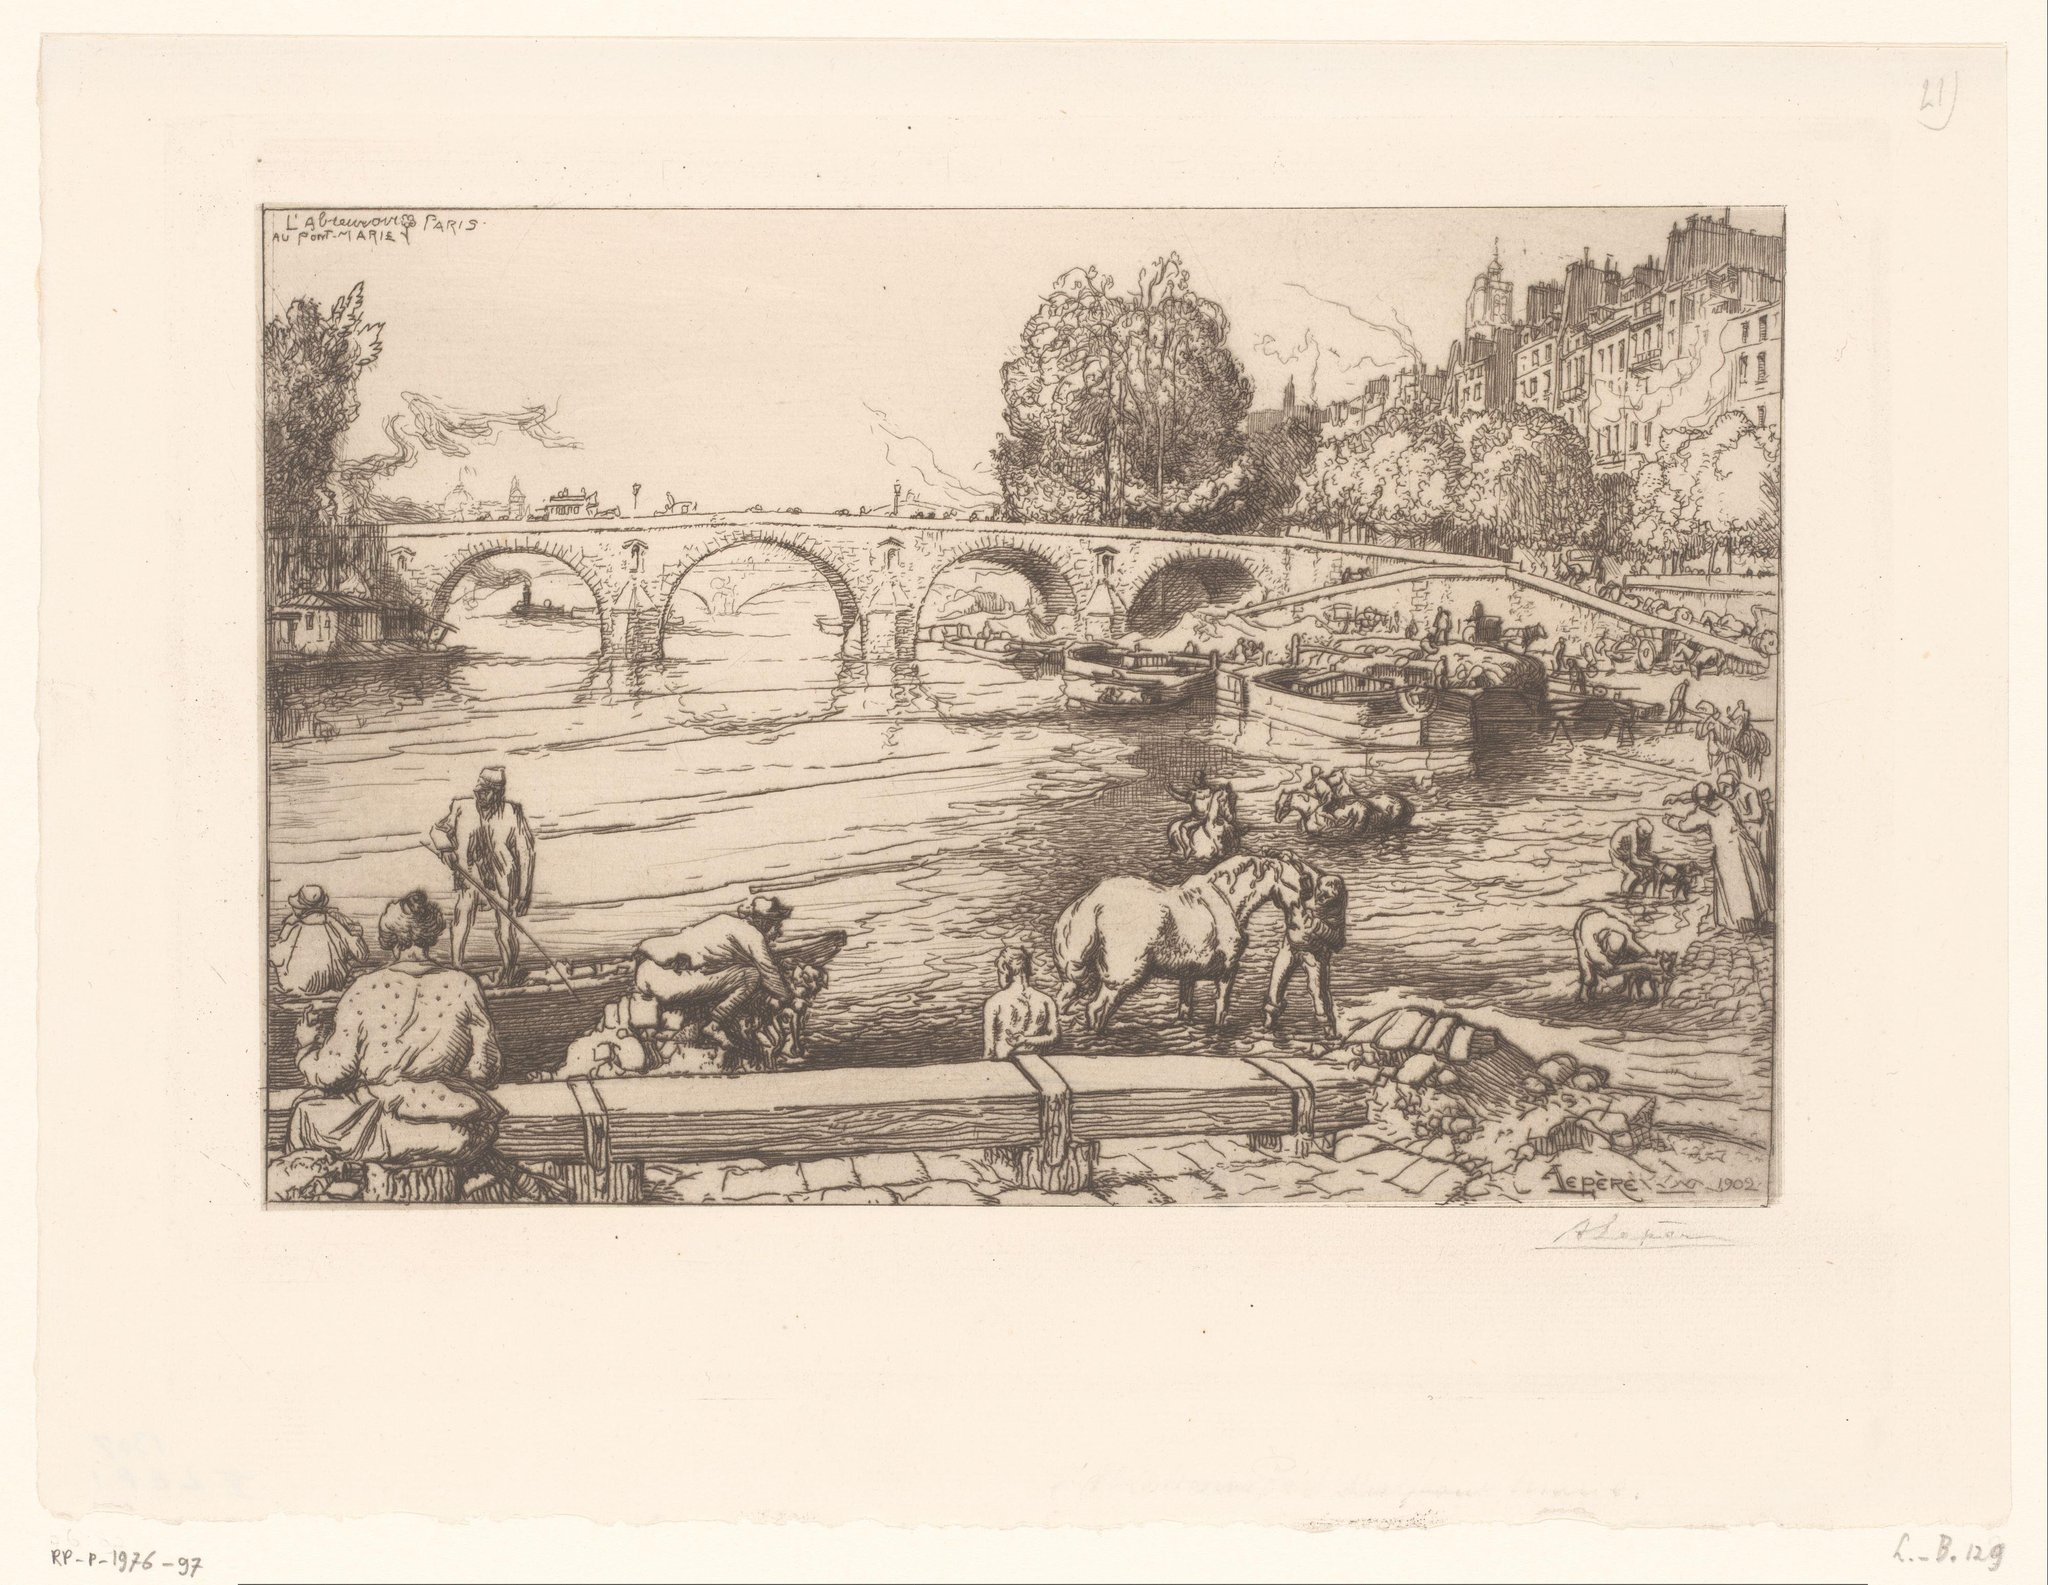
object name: print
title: Gezicht op de Pont Marie met figuren in de Seine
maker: auguste lepère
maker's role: print maker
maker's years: 1849-1918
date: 1902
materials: paper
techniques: etching, intaglio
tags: city-view in general; 'veduta', bridge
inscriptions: collector's mark: Lugt 4731, collector's mark: Lugt 2228